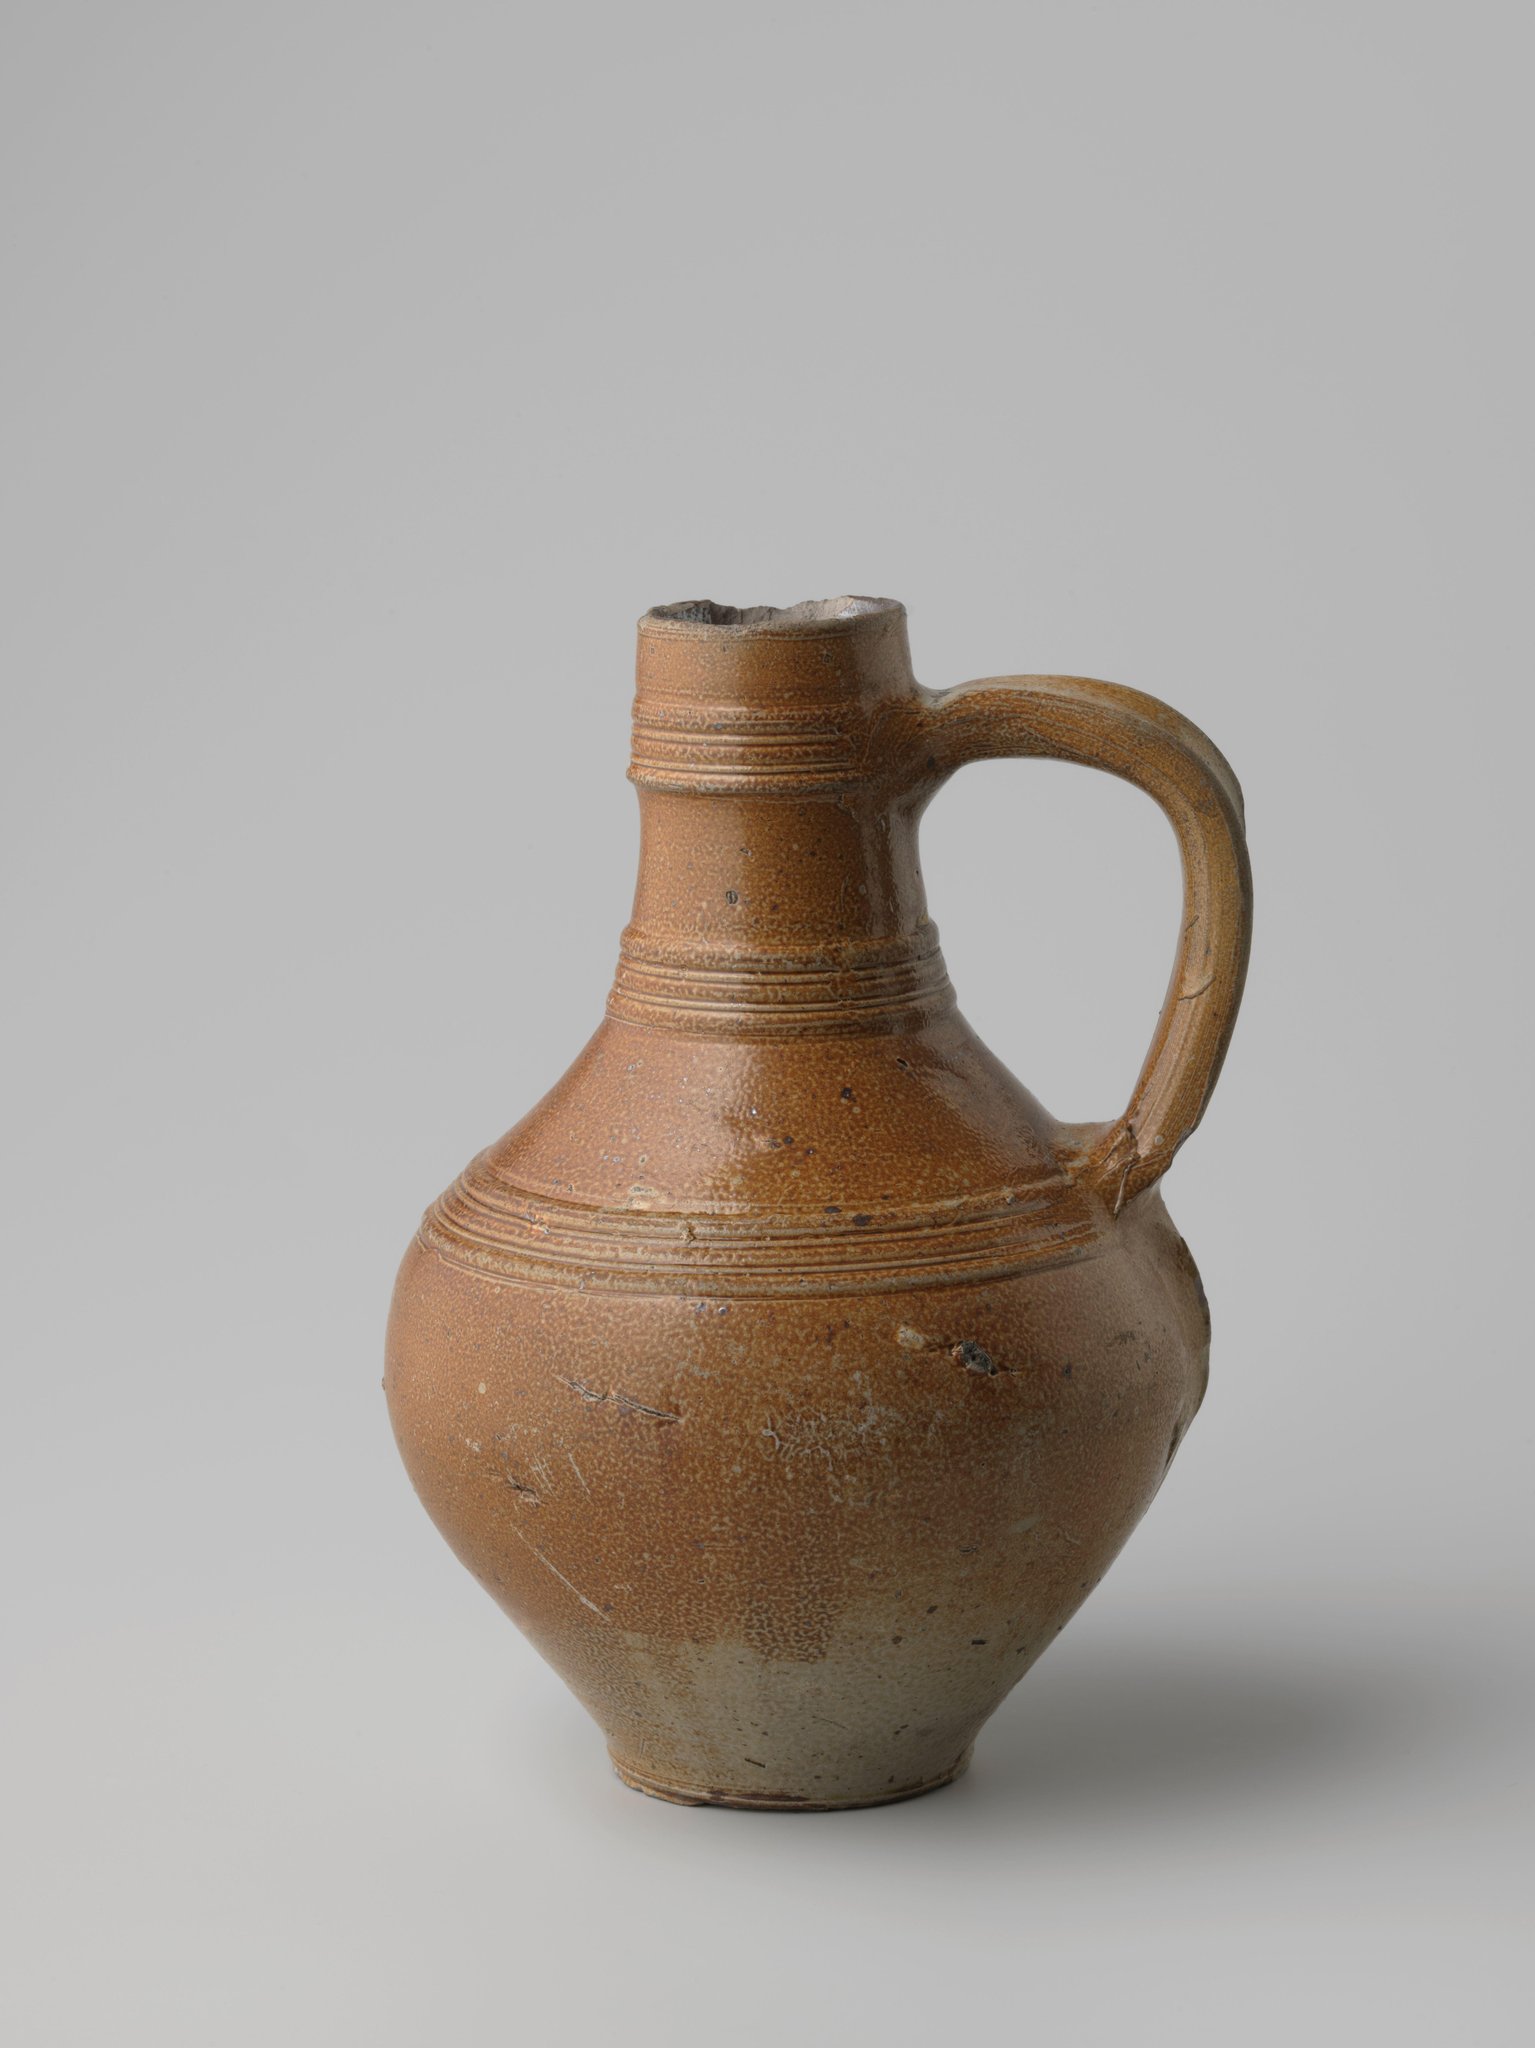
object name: jug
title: Jug with horizontal borders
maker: Anonymous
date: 1550-1599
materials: engobe, glaze, stoneware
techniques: firing, forming, turning, vitrification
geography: raeren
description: Kruik van steengoed op standring met een eivormig lichaam en lange nek. Het C-vormige oor is bevestigd aan de nek en de schouder. Bedekt met een bruine engobe. Op de nek en het lichaam drie brede horizontale banden met profiel. Bodem ontbreekt. Raeren.